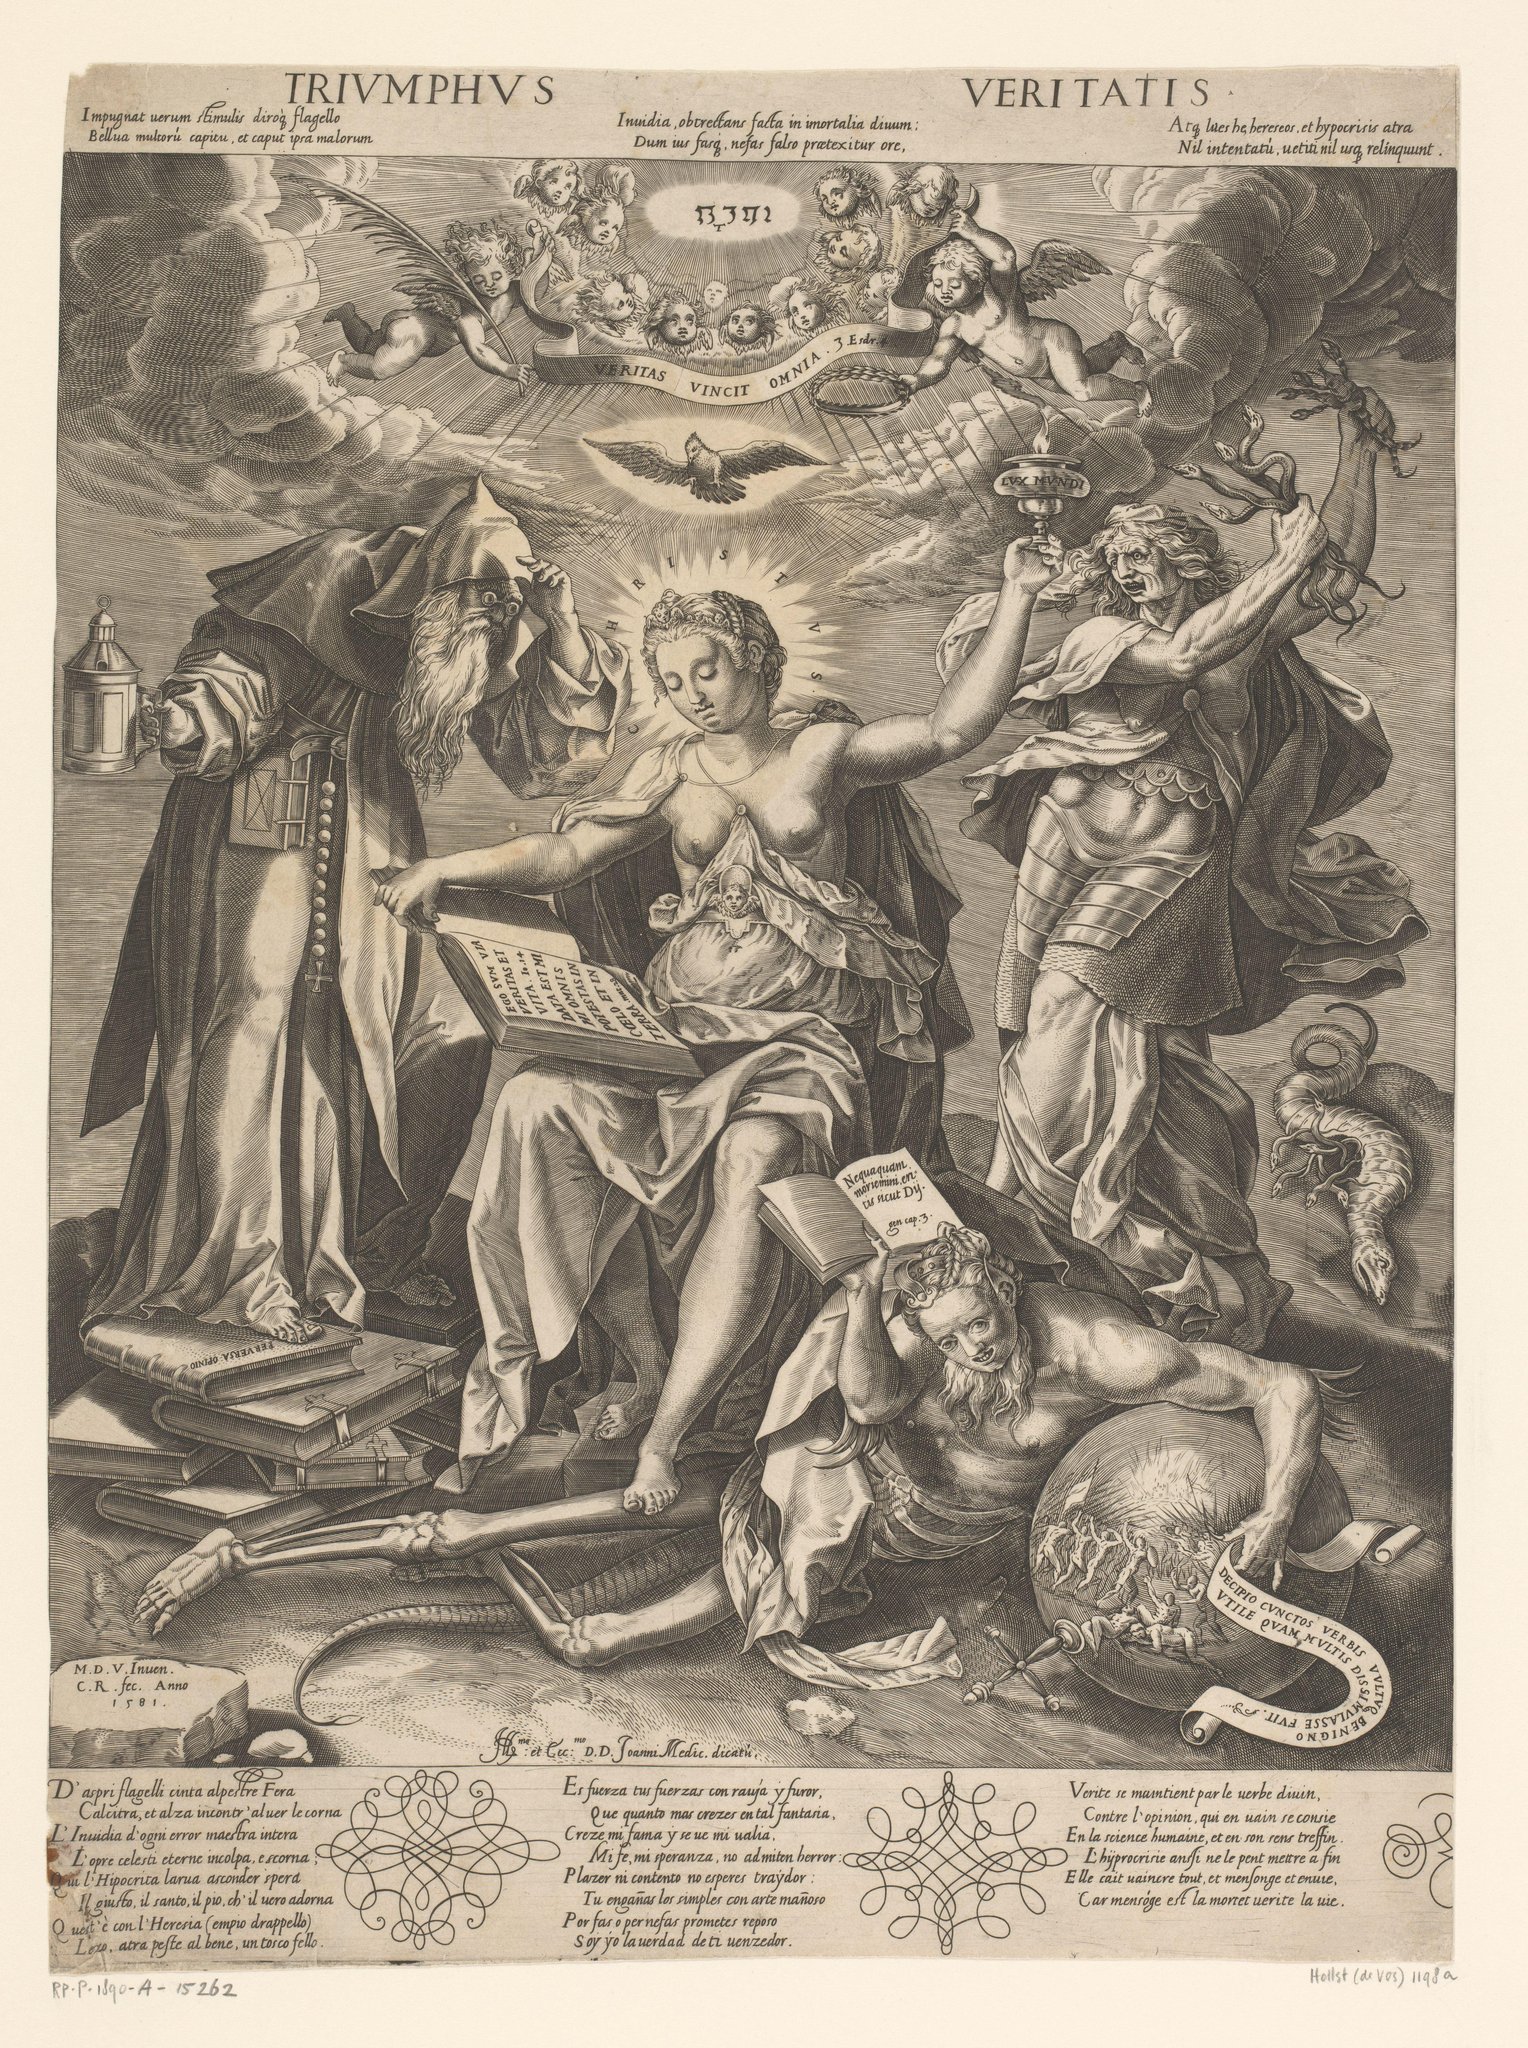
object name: print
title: Triumphus veritatis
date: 1581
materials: paper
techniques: engraving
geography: antwerp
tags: truth; 'verità' (ripa) (+ allegorical scene, i.e. two or more personifications involved in an action), opinion (+ allegorical scene, i.e. two or more personifications involved in an action), falsehood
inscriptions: collector's mark: Lugt 2228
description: In het midden troont de personificatie van de Waarheid, die zich vereenzelvigt met Christus. Op haar schoot een opengeslagen boek met Bijbelse spreuken. Ze houdt een brandende olielamp omhoog als licht van de wereld. Haar voet rust op een wezen, de Leugen, waarvan de ene helft uit een skelet bestaat en de andere helft uit een vrouw. Het wezen omarmt een wereldbol met een kruis. Links staat de personificatie van de (onjuiste) Opinie in de gedaante van een oude man in een pij met een bril en een lantaarn, die op een stapel boeken staat. Rechts de personificatie van de Hipocrisie met slangen en een kreeft in haar handen. Boven houden een putto met een palmtak en een putto met een lauwerkrans (symbolen van overwinning) een banderol vast met de Latijnse vertaling van: Waarheid overwint alles. Boven hen Serafijnen en onder de banderol de Heilige Geest. Boven een zesregelige tekst in het Latijn en onder de voorstelling verzen in het Italiaans, Spaans en Frans.